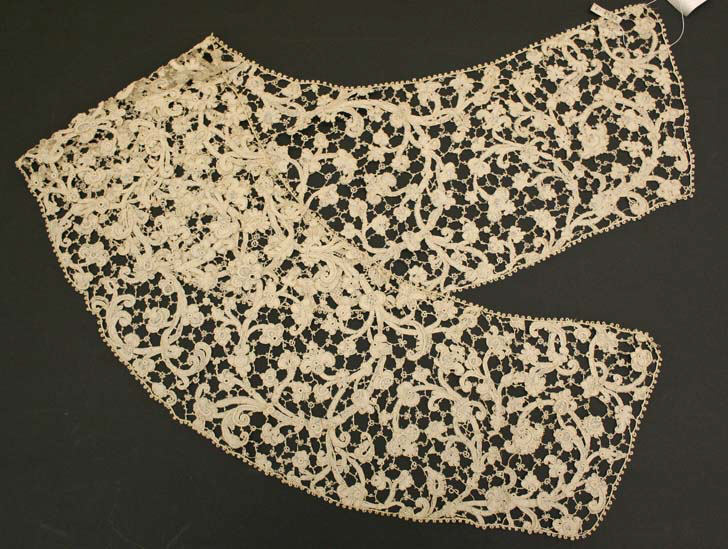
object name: collar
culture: italian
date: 1601-1700